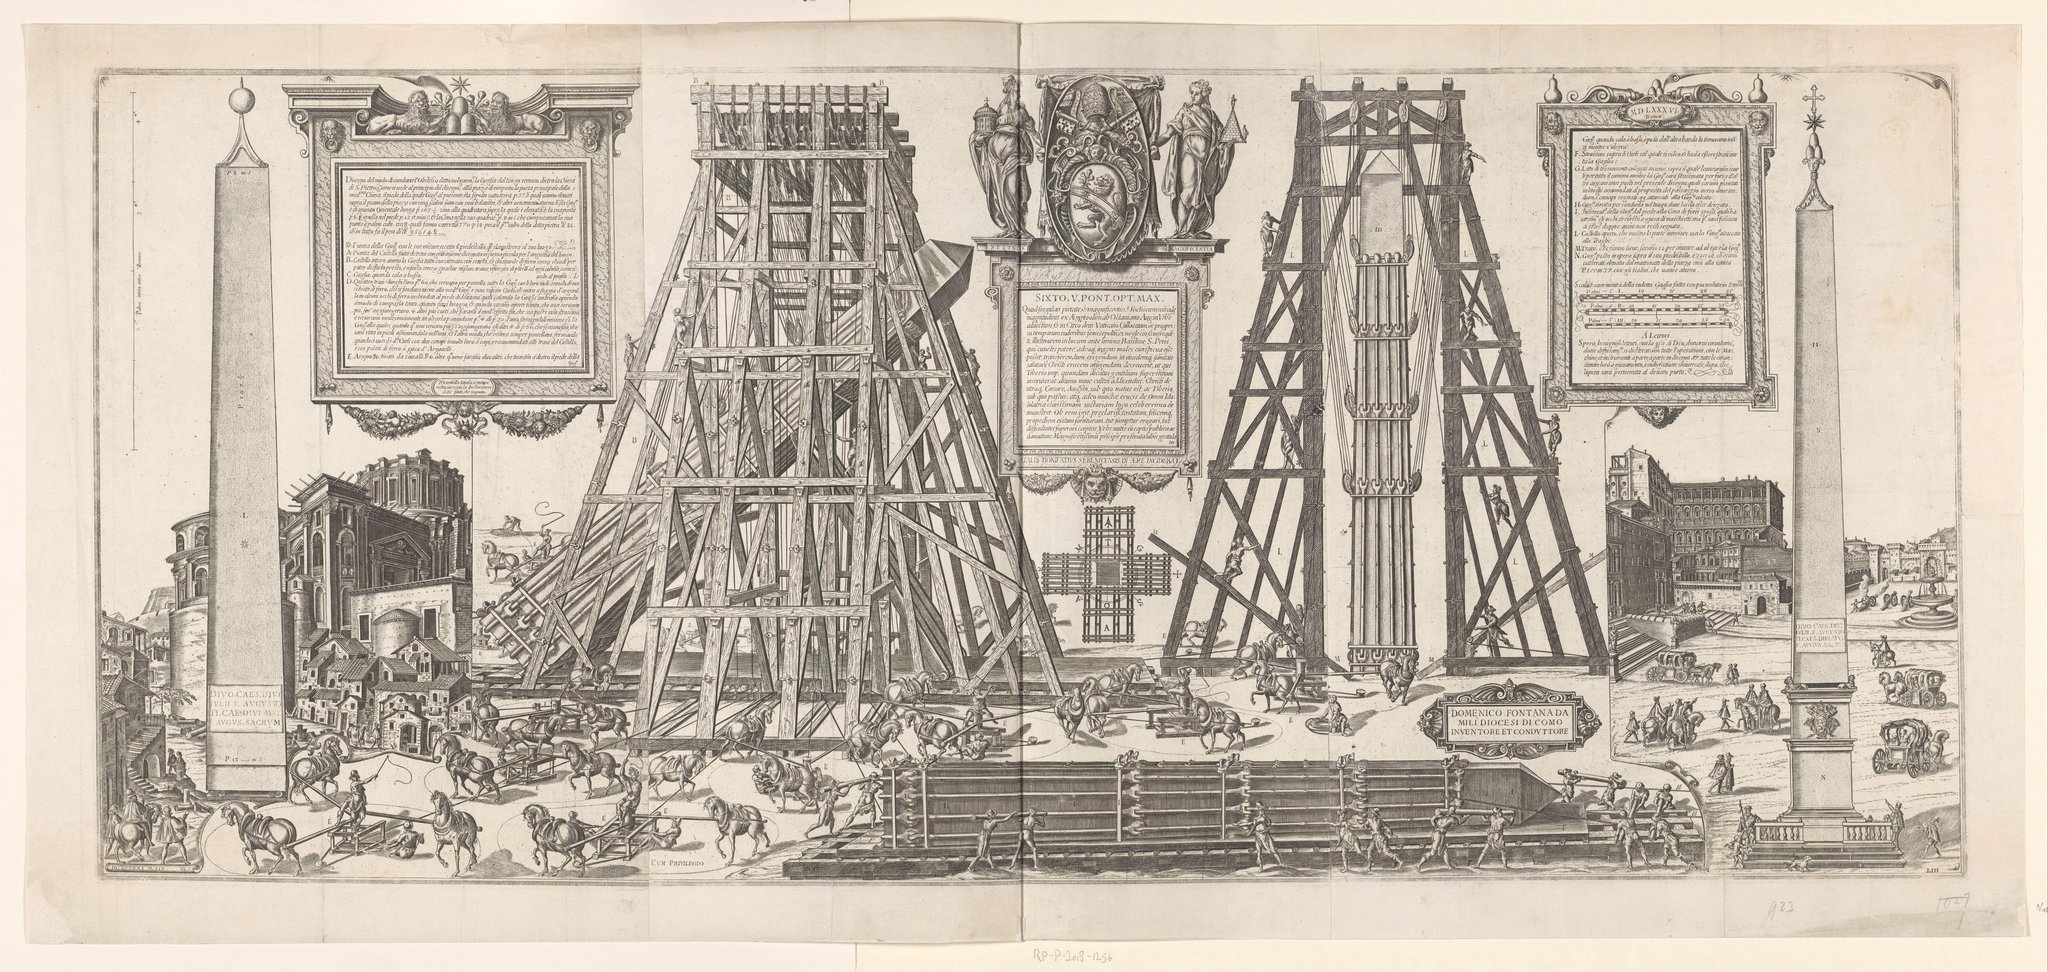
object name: print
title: Domenico Fotana da Mili diocesi di Como inventore e conduttore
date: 1586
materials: paper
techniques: engraving, etching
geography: rome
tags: rome, sixtus v, switzerland, domenico fontana, obelisk, needle, roman catholic church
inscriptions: collector's mark: Lugt 2228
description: Linkerdeel: Links de Vaticaanse Obelisk die rechtop staat, bekroond met een koperen bol. Rechts mannen en paarden die de Vaticaanse Obelisk op zijn nieuwe verblijfplaats, het St. Pietersplein, rechtop zetten met behulp van een houten stellage. Rechtsboven een sierlijst met tekst. Middelste deel: Mannen en paarden zijn bezig met het oprichten van de Vaticaanse Obelisk (in 1586) op het Sint-Pietersplein, met behulp van een grote houten stellage. Rechtsboven een sierlijst met tekst, het wapen van paus Sixtus V en personificaties van Religie en Grootsheid. Rechtsonder mannen die de obelisk transporteren met behulp van ronde palen. Rechterdeel: Links de Vaticaanse Obelisk die rechtop staat. Om de obelisk is een houten stellage gebouwd. Linksonder mannen die de obelisk transporteren met behulp van ronde palen. Rechts de Vaticaanse Obelisk op het Sint-Pietersplein, bekroond met een kruis. Boven, in het midden, een sierlijst met verklarende lijst met letters.